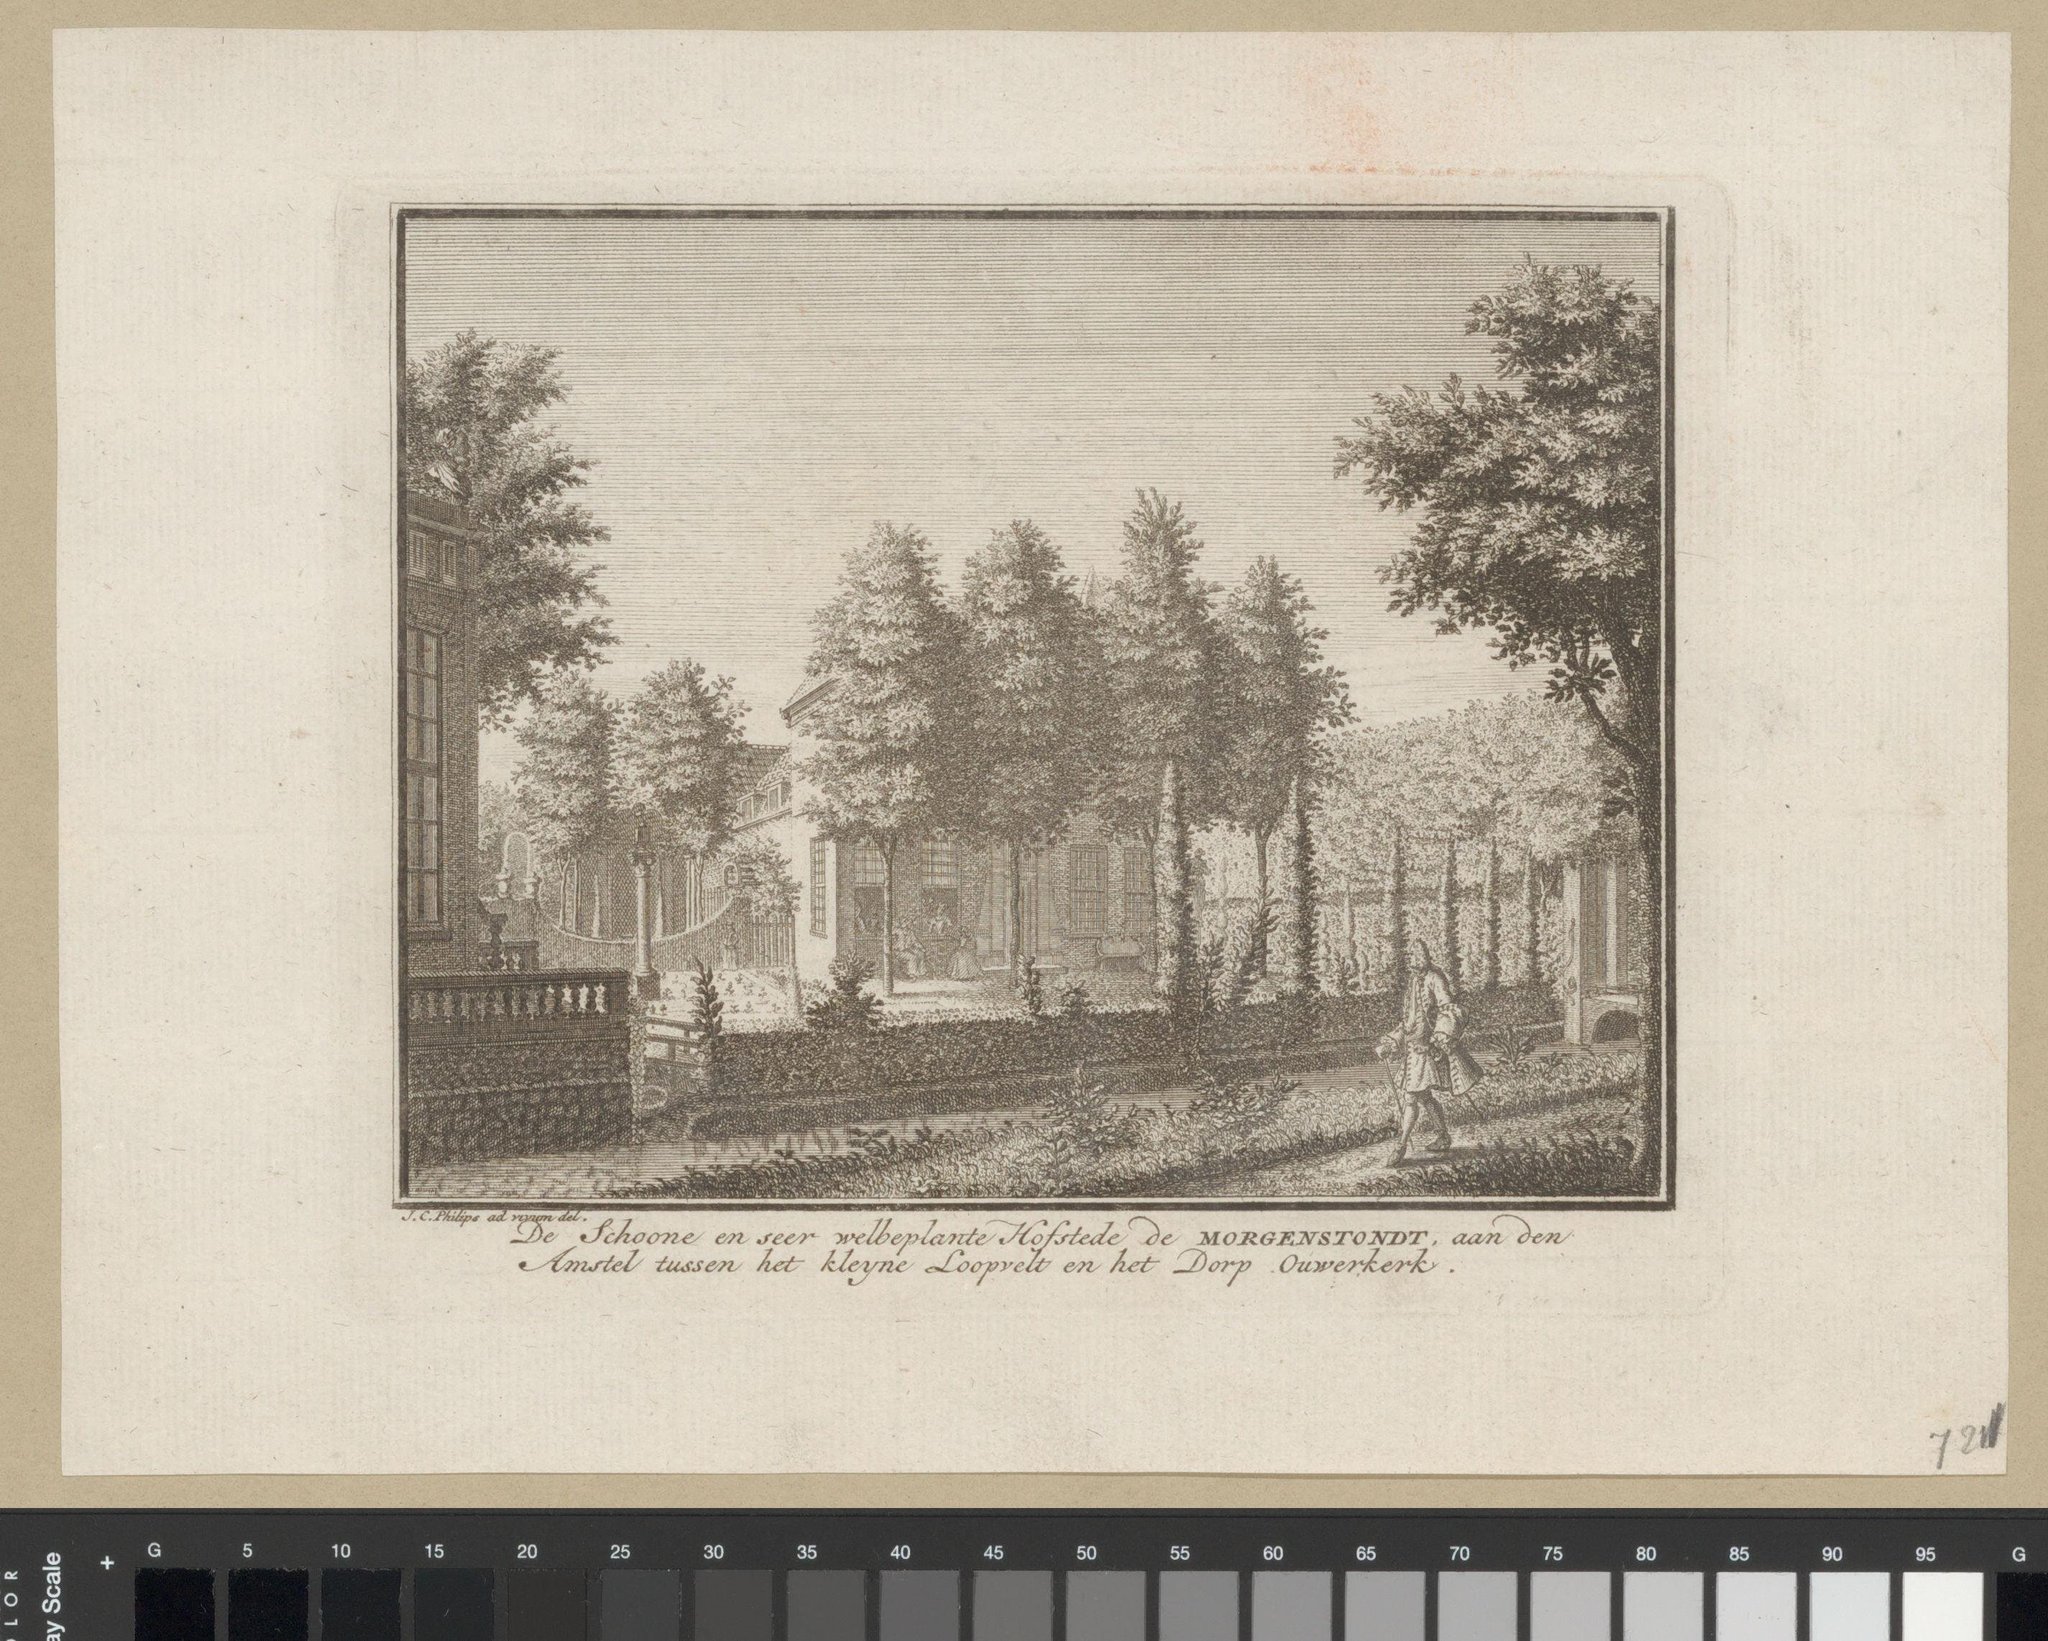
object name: print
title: Gezicht op hofstede De Morgenstondt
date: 1730-1799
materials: paper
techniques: etching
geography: amsterdam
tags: city-view in general; 'veduta', rural housing, e.g. country-house, villa, cottage, road, path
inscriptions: collector's mark: ‘5’ Lugt 1641b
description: Onderwerpsrubriek binnen de Atlas Amsterdam: Amstel buiten de stad, Amsteldijk.